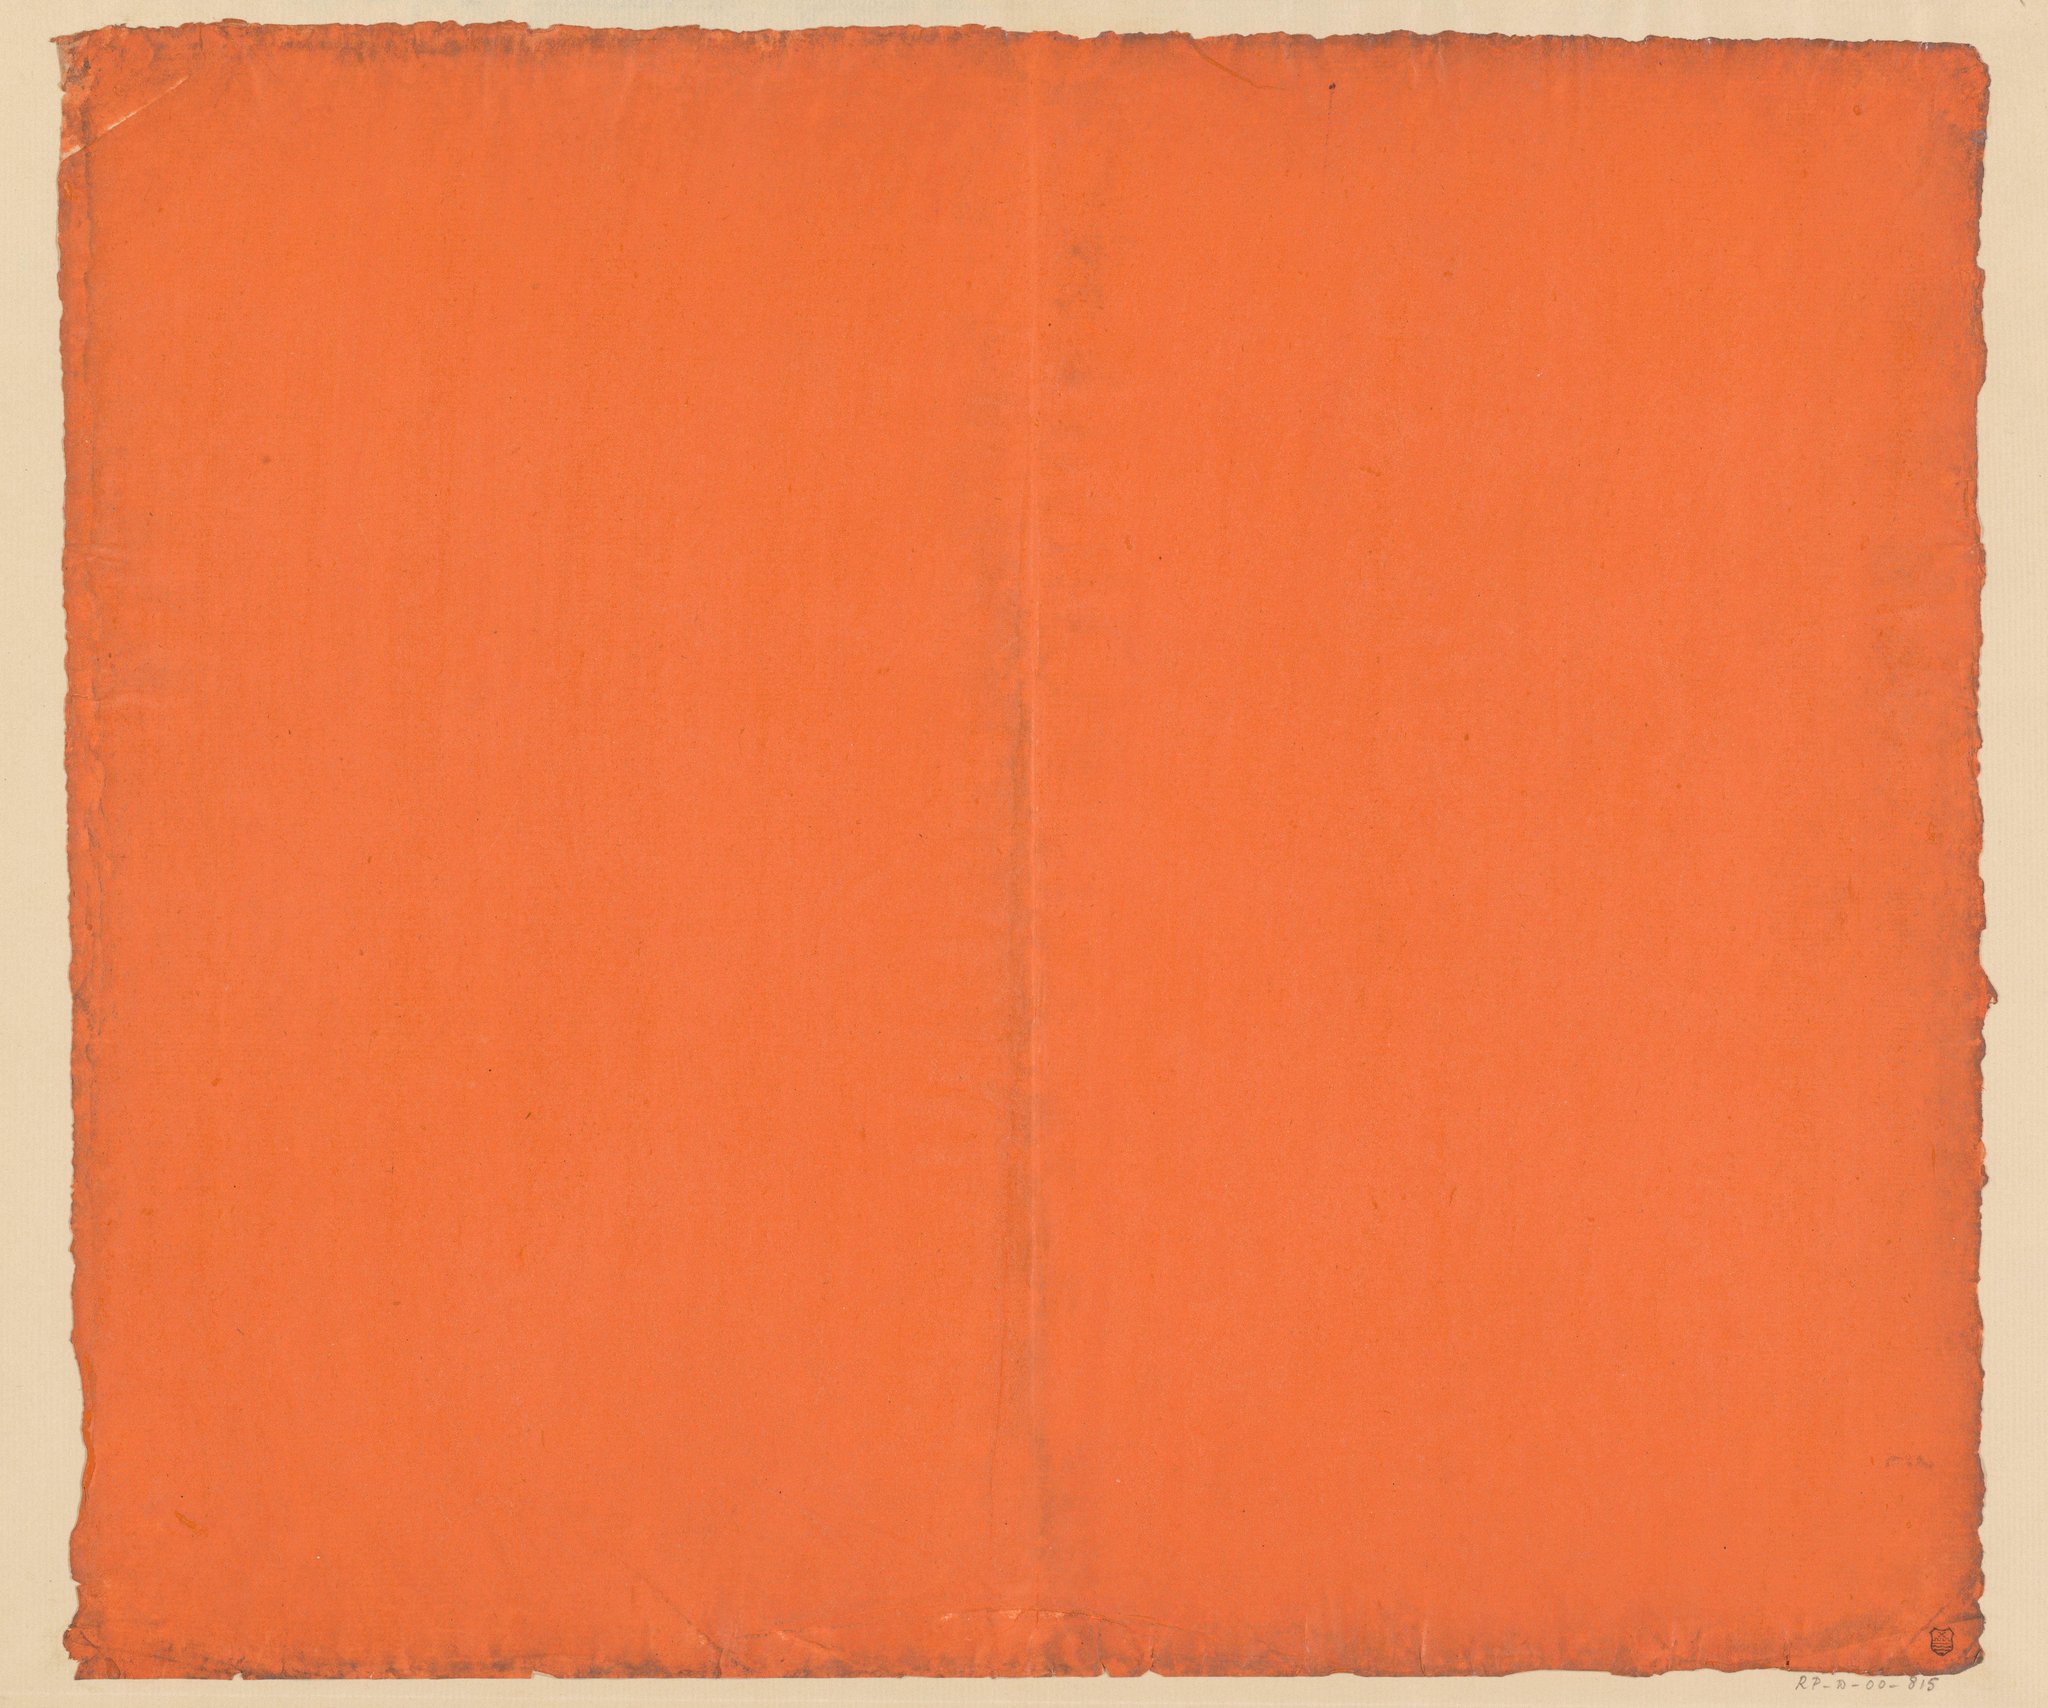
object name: decorated paper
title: Effen oranje papier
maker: Anonymous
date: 1800-1900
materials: lacquer, paint, paper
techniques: hand coloring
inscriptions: collector's mark: Lugt 2760